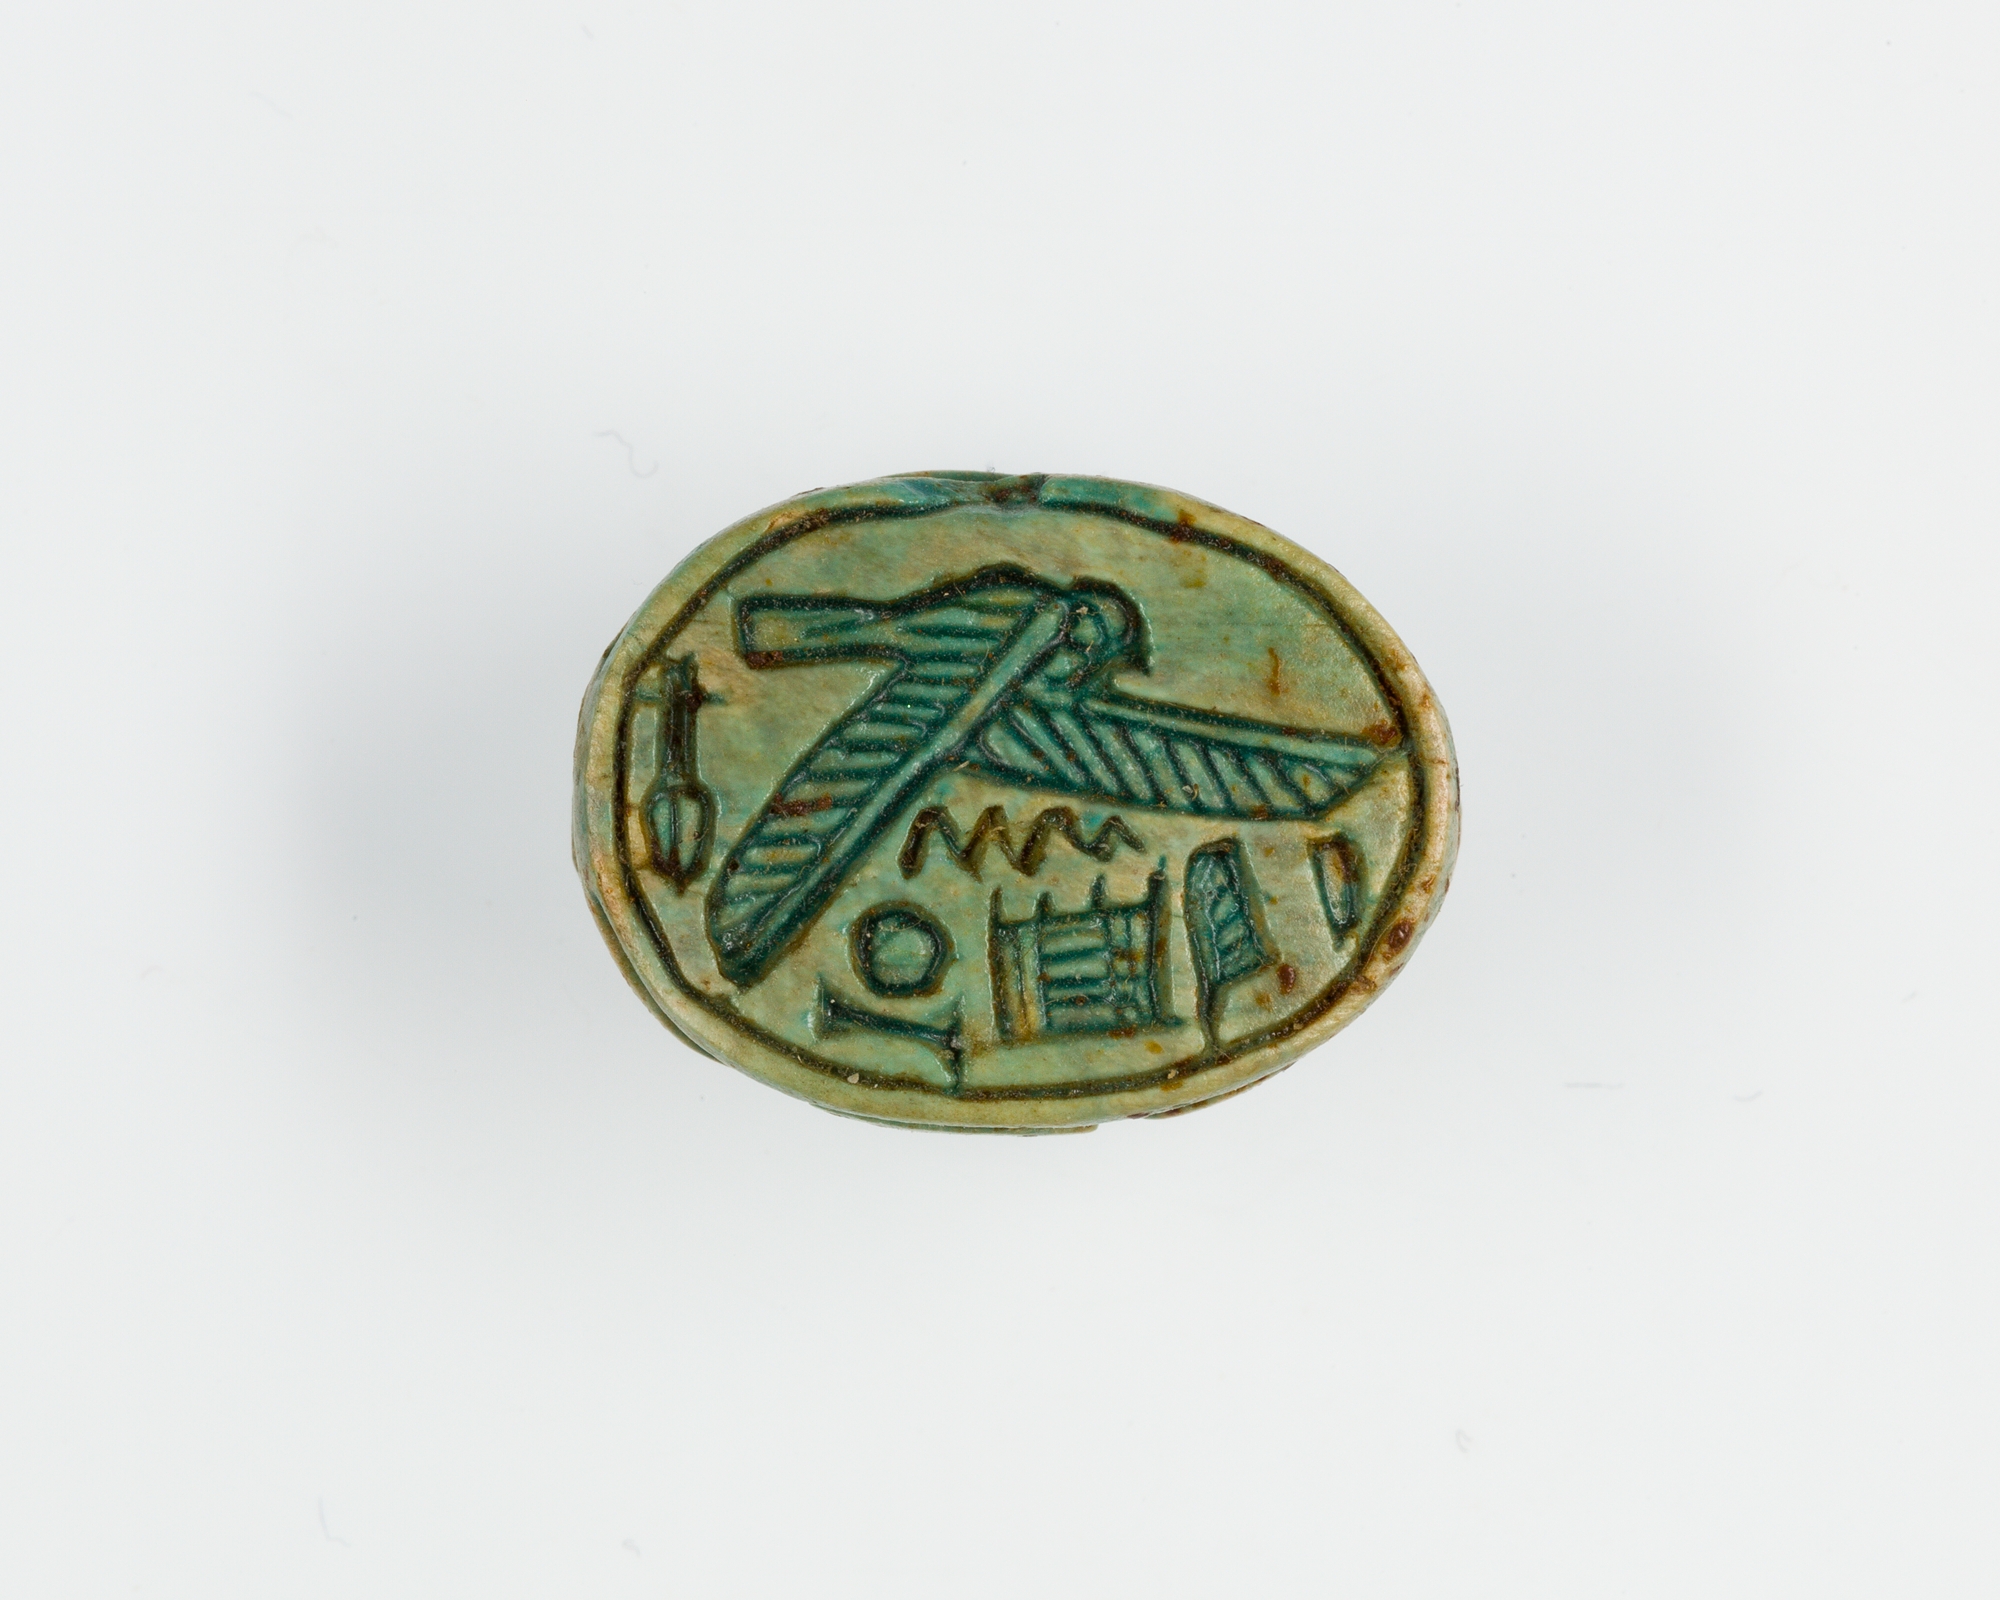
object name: scarab, amun re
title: Scarab Inscribed With the Name of Amun-Re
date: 1479-1458 BCE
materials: stone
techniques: glazing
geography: egypt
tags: hieroglyphs,scarabs